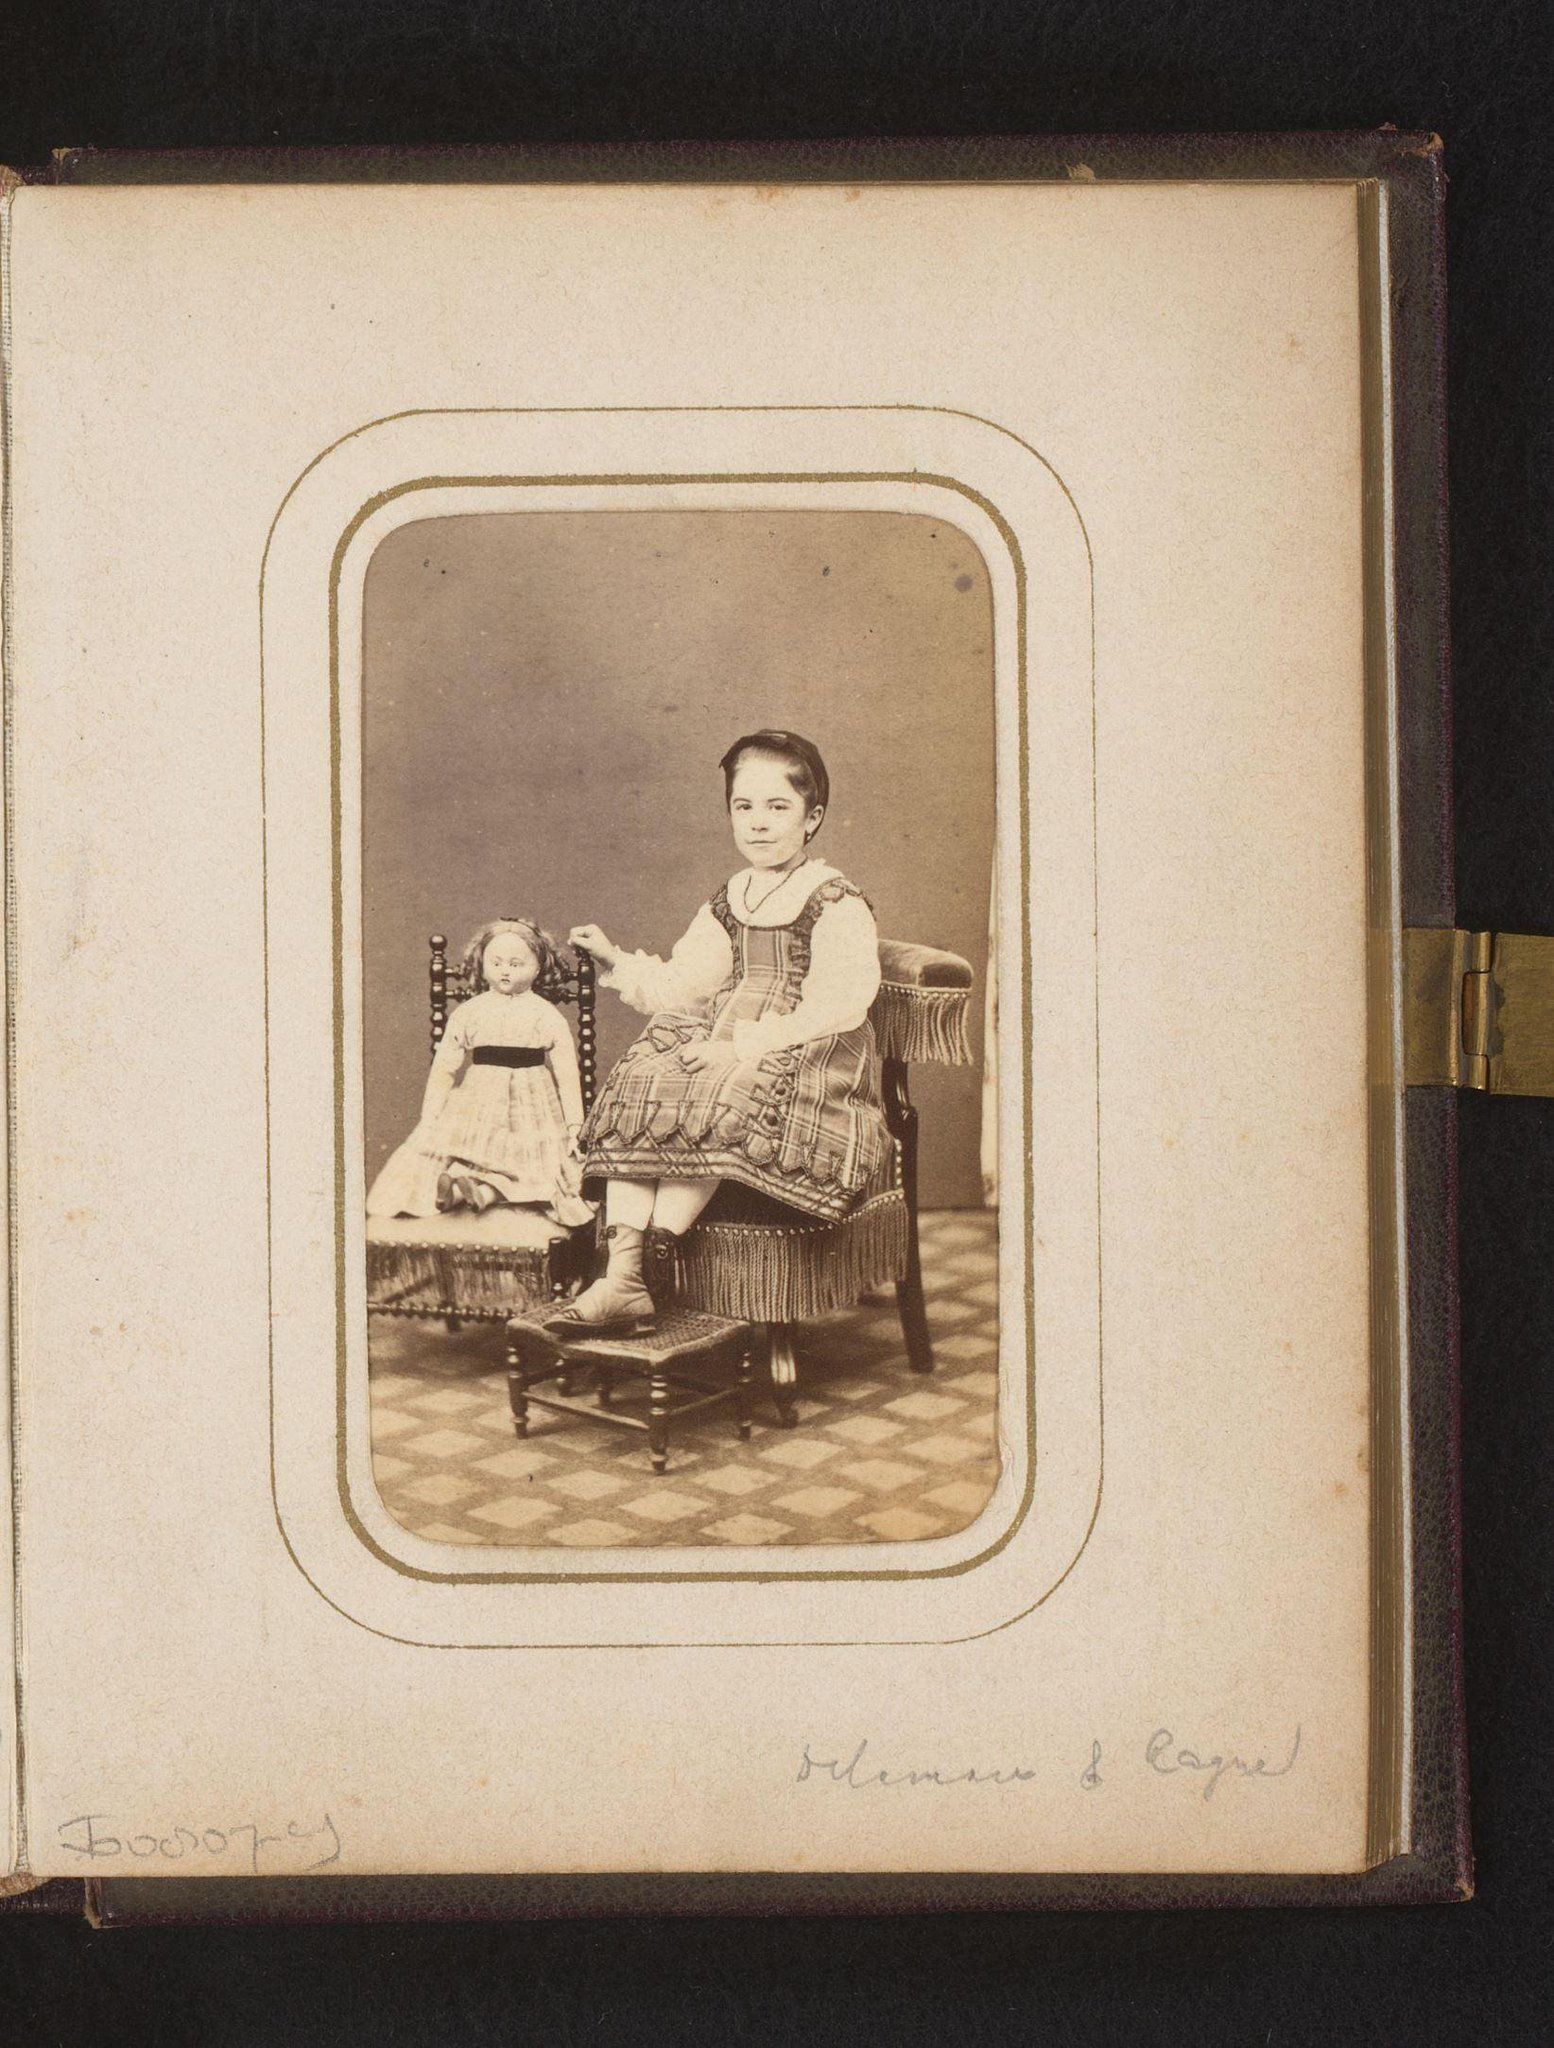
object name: album leaf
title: Portret van een zittend meisje met voetenbankje en een pop op een stoel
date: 1860-1900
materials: cardboard, photographic support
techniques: albumen print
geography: elbeuf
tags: footstool, sitting figure - aa - female human figure, historical persons - bb - woman, girl (child between toddler and youth), (playing with) dolls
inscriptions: inscription: ‘PHOTOGRAPHE/ A. DELAMARE & A. RAGUET/ 7, Rue de Paris, 7/ ELBEUF’, annotation: ‘Delamare & Raguet’